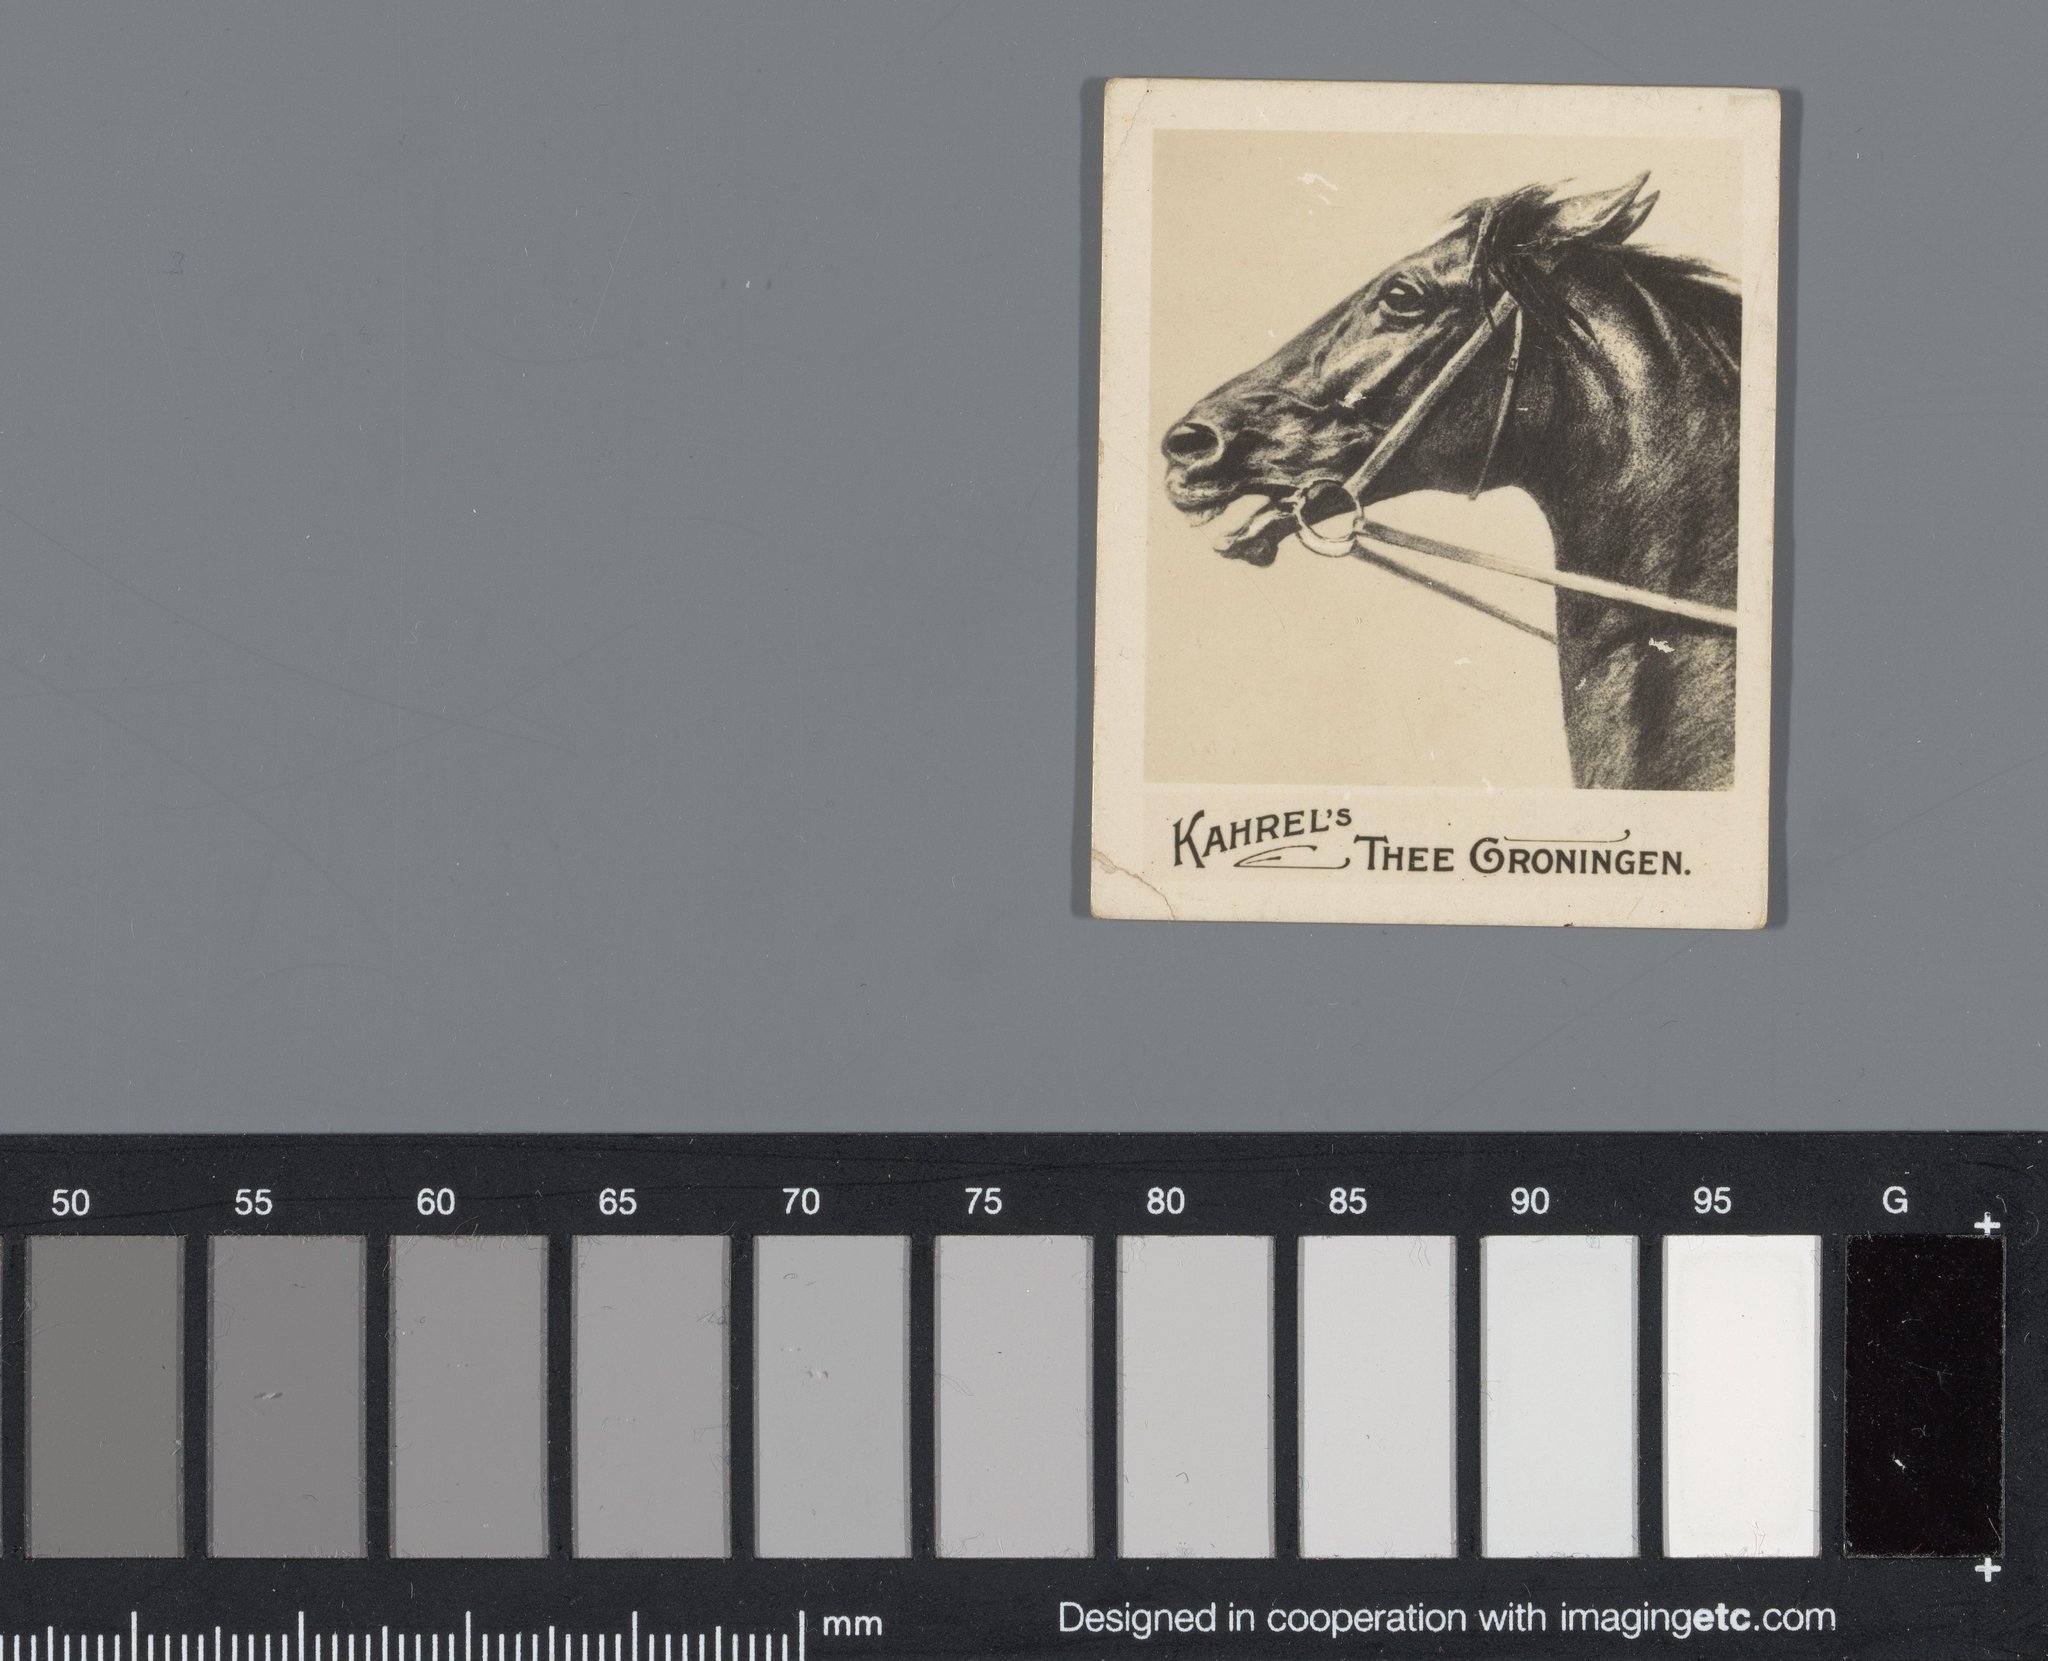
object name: photograph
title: Hoofd van een paard, reclame voor Kahrel's Thee Groningen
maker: Anonymous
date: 1895-1910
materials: paper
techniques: gelatin silver print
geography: groningen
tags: horse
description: Dergelijke foto's stonden bekend als 'zwartjes'. Men verkreeg ze bij aanschaf van bepaalde merken thee, cacao, sigaretten, beschuit, etc. om te verzamelen. Er waren speciaal voor de 'zwartjes' verzamelalbums in omloop.